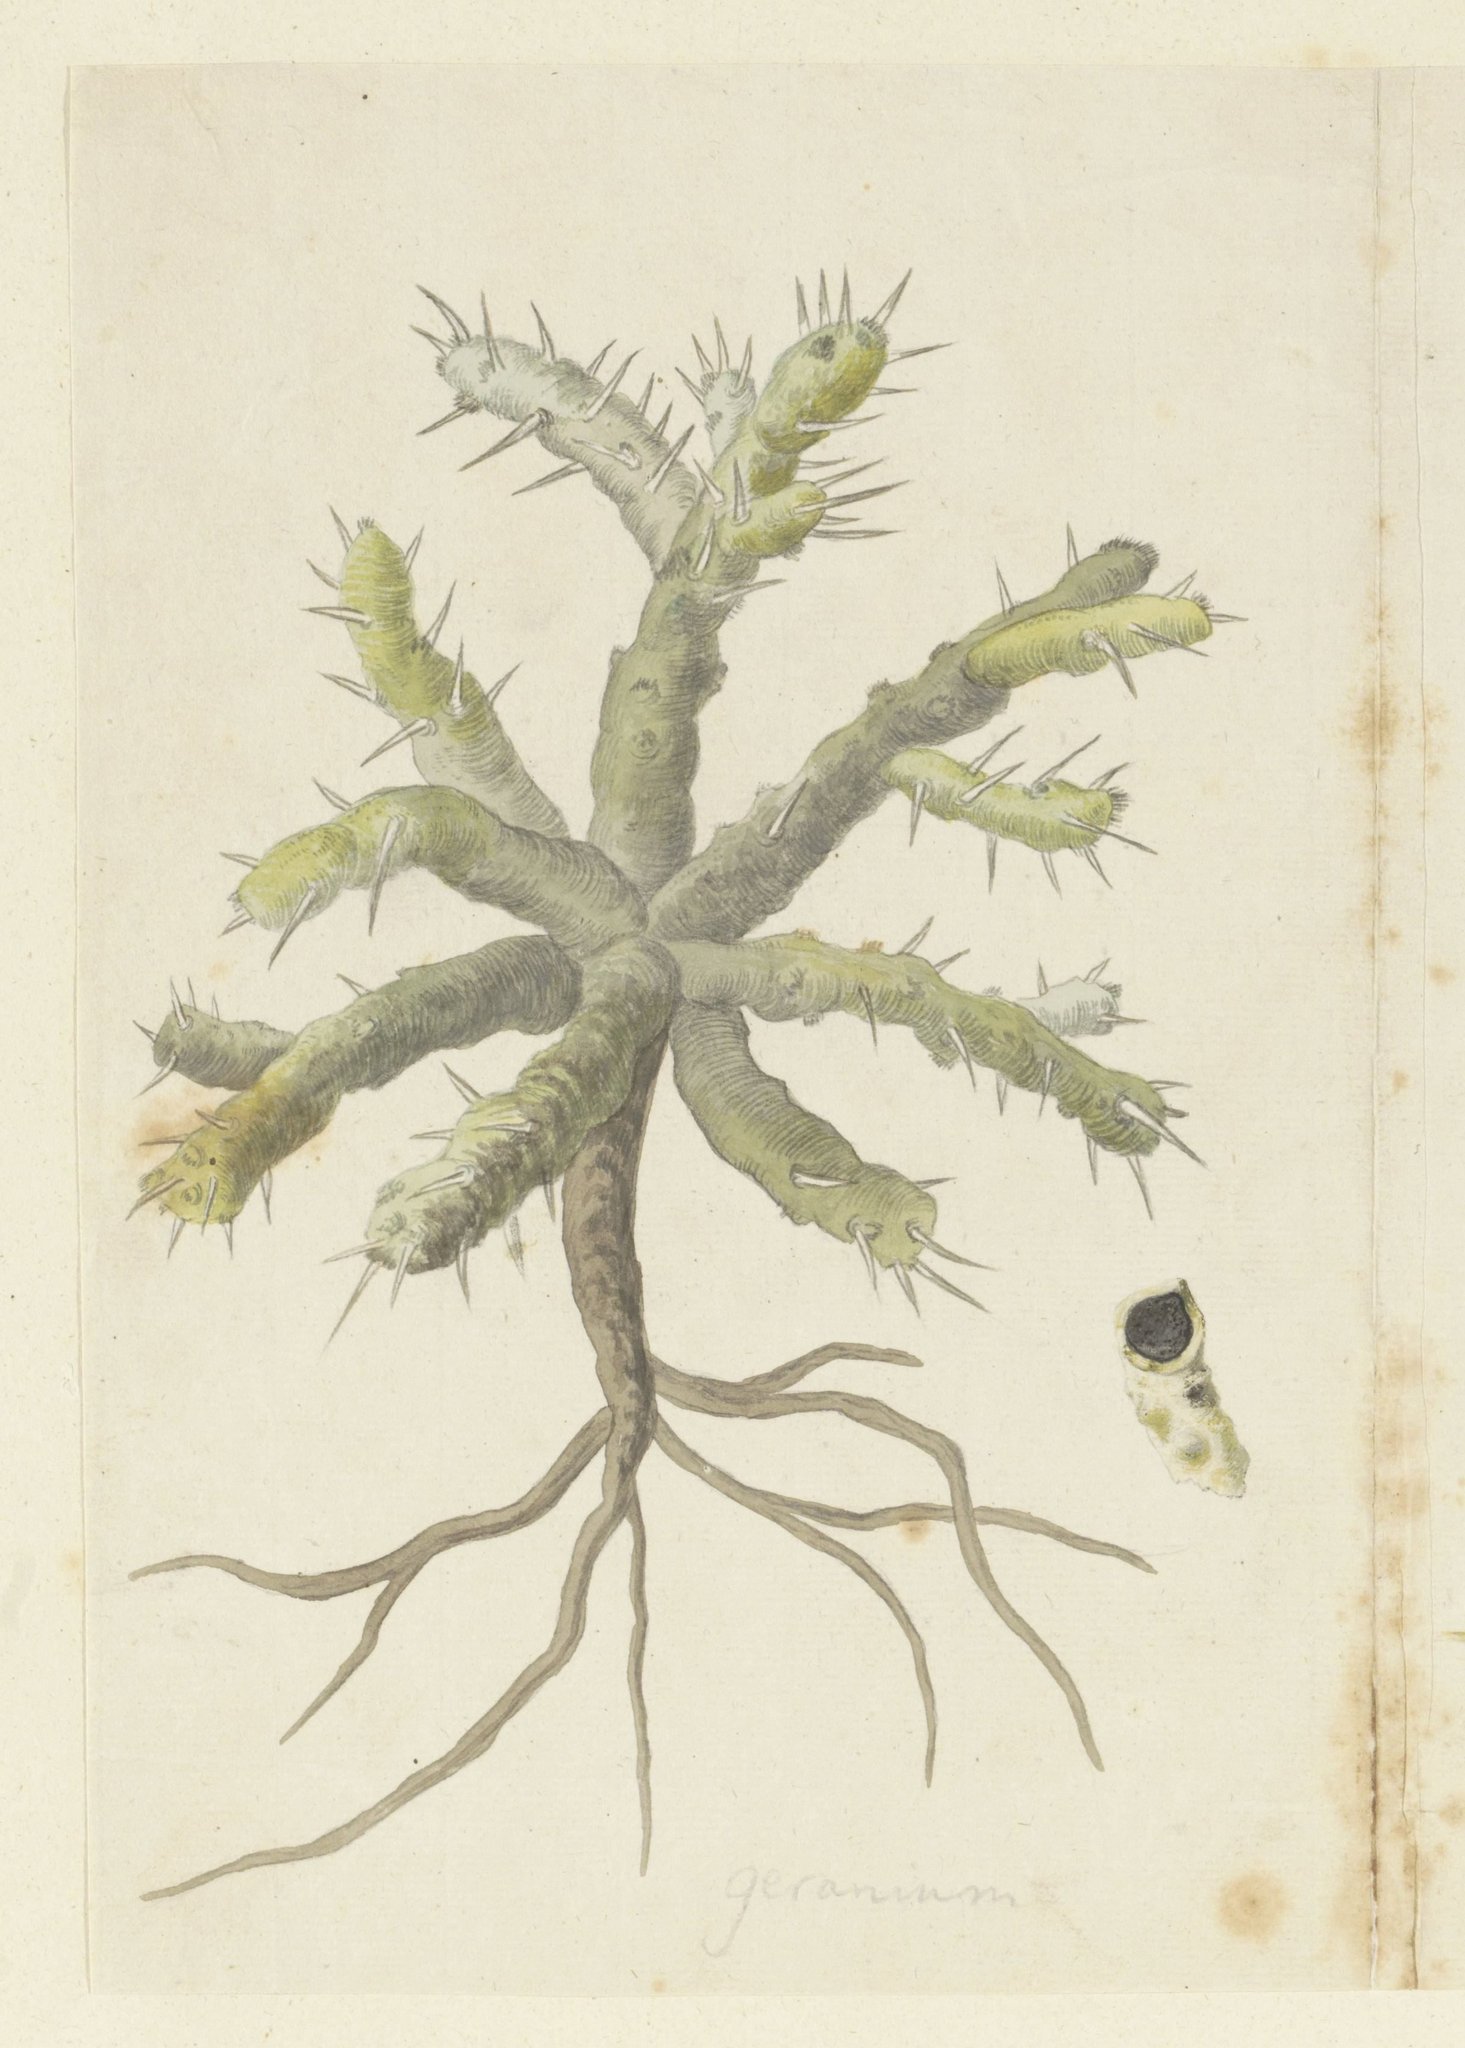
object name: album leaf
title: Monsonia patersonii or Monsonia sp.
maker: robert jacob gordon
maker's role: draughtsman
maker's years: 1743-1795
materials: chalk, paper, pencil, watercolor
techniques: brush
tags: plants; vegetation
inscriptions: annotation: ‘geranium’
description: De tekening is gemaakt voor of tijdens een van Gordon's vier expedities door de Kaapprovincie, van oktober 1777 tot maart 1786. Sommige (soort)namen kunnen zijn gewijzigd, gezien reorganisatie in plantentaxonomie gedurende de afgelopen jaren.